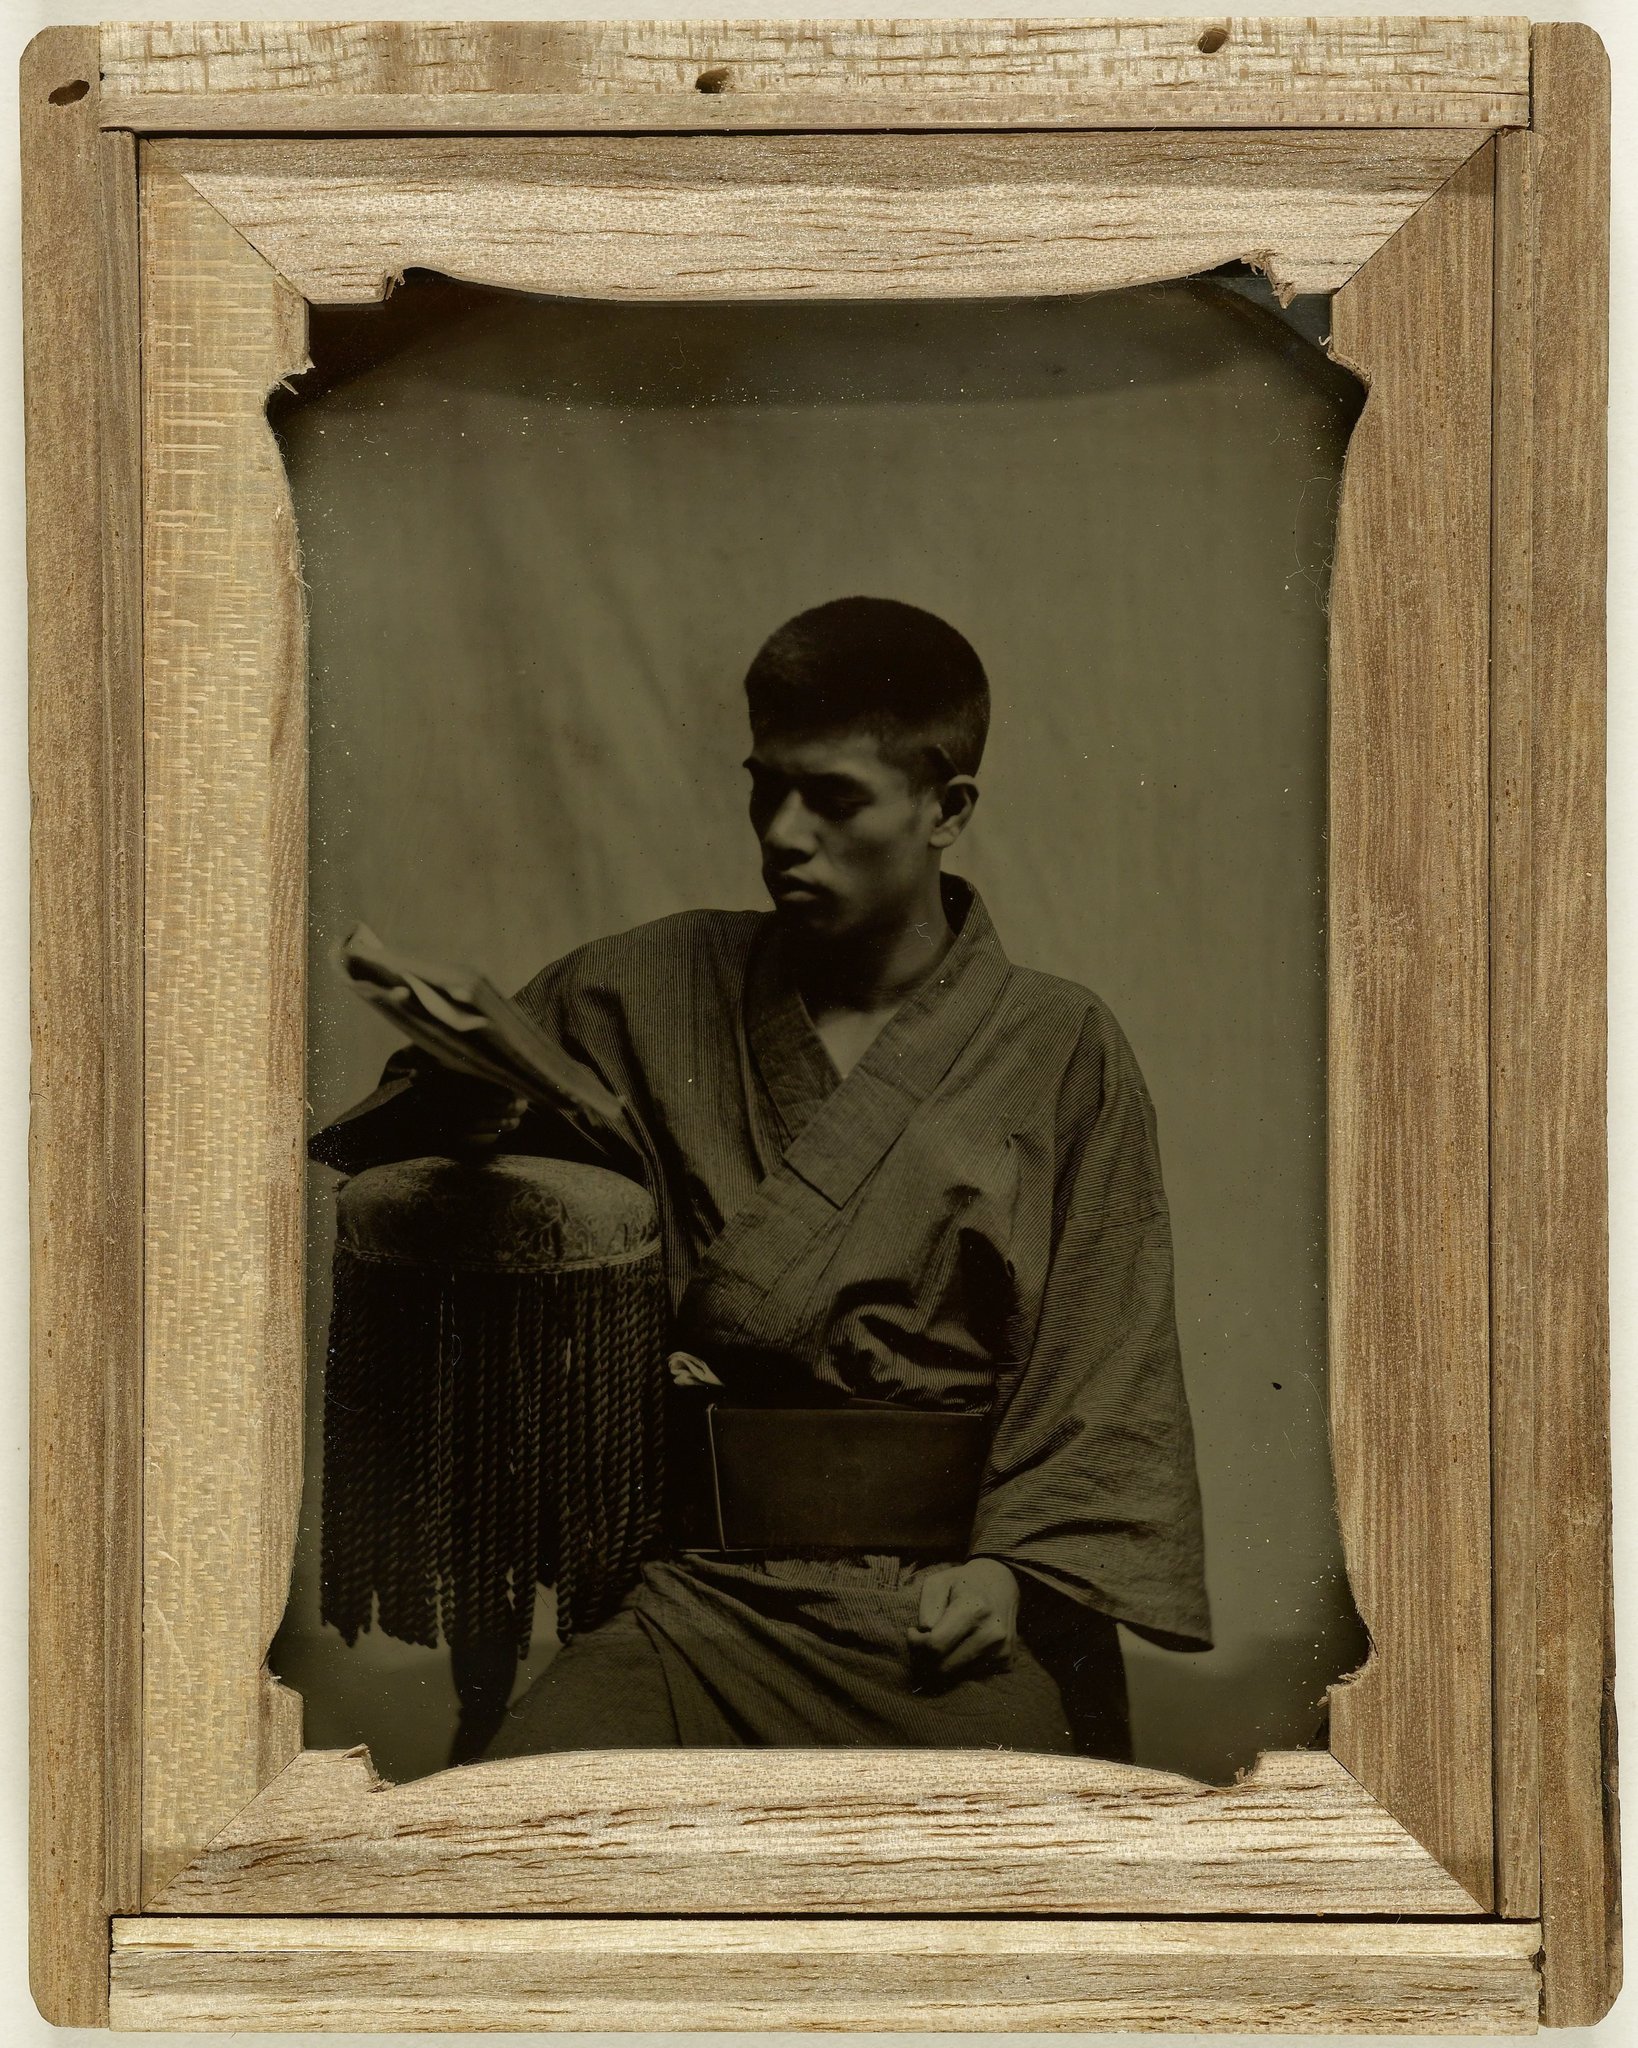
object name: photograph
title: Portret van Yamada Kistuji, een boek lezend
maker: Anonymous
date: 1884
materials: wood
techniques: ambrotype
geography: tokyo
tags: reading, historical persons, japan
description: Portret van een man die een Japans boekje bekijkt.